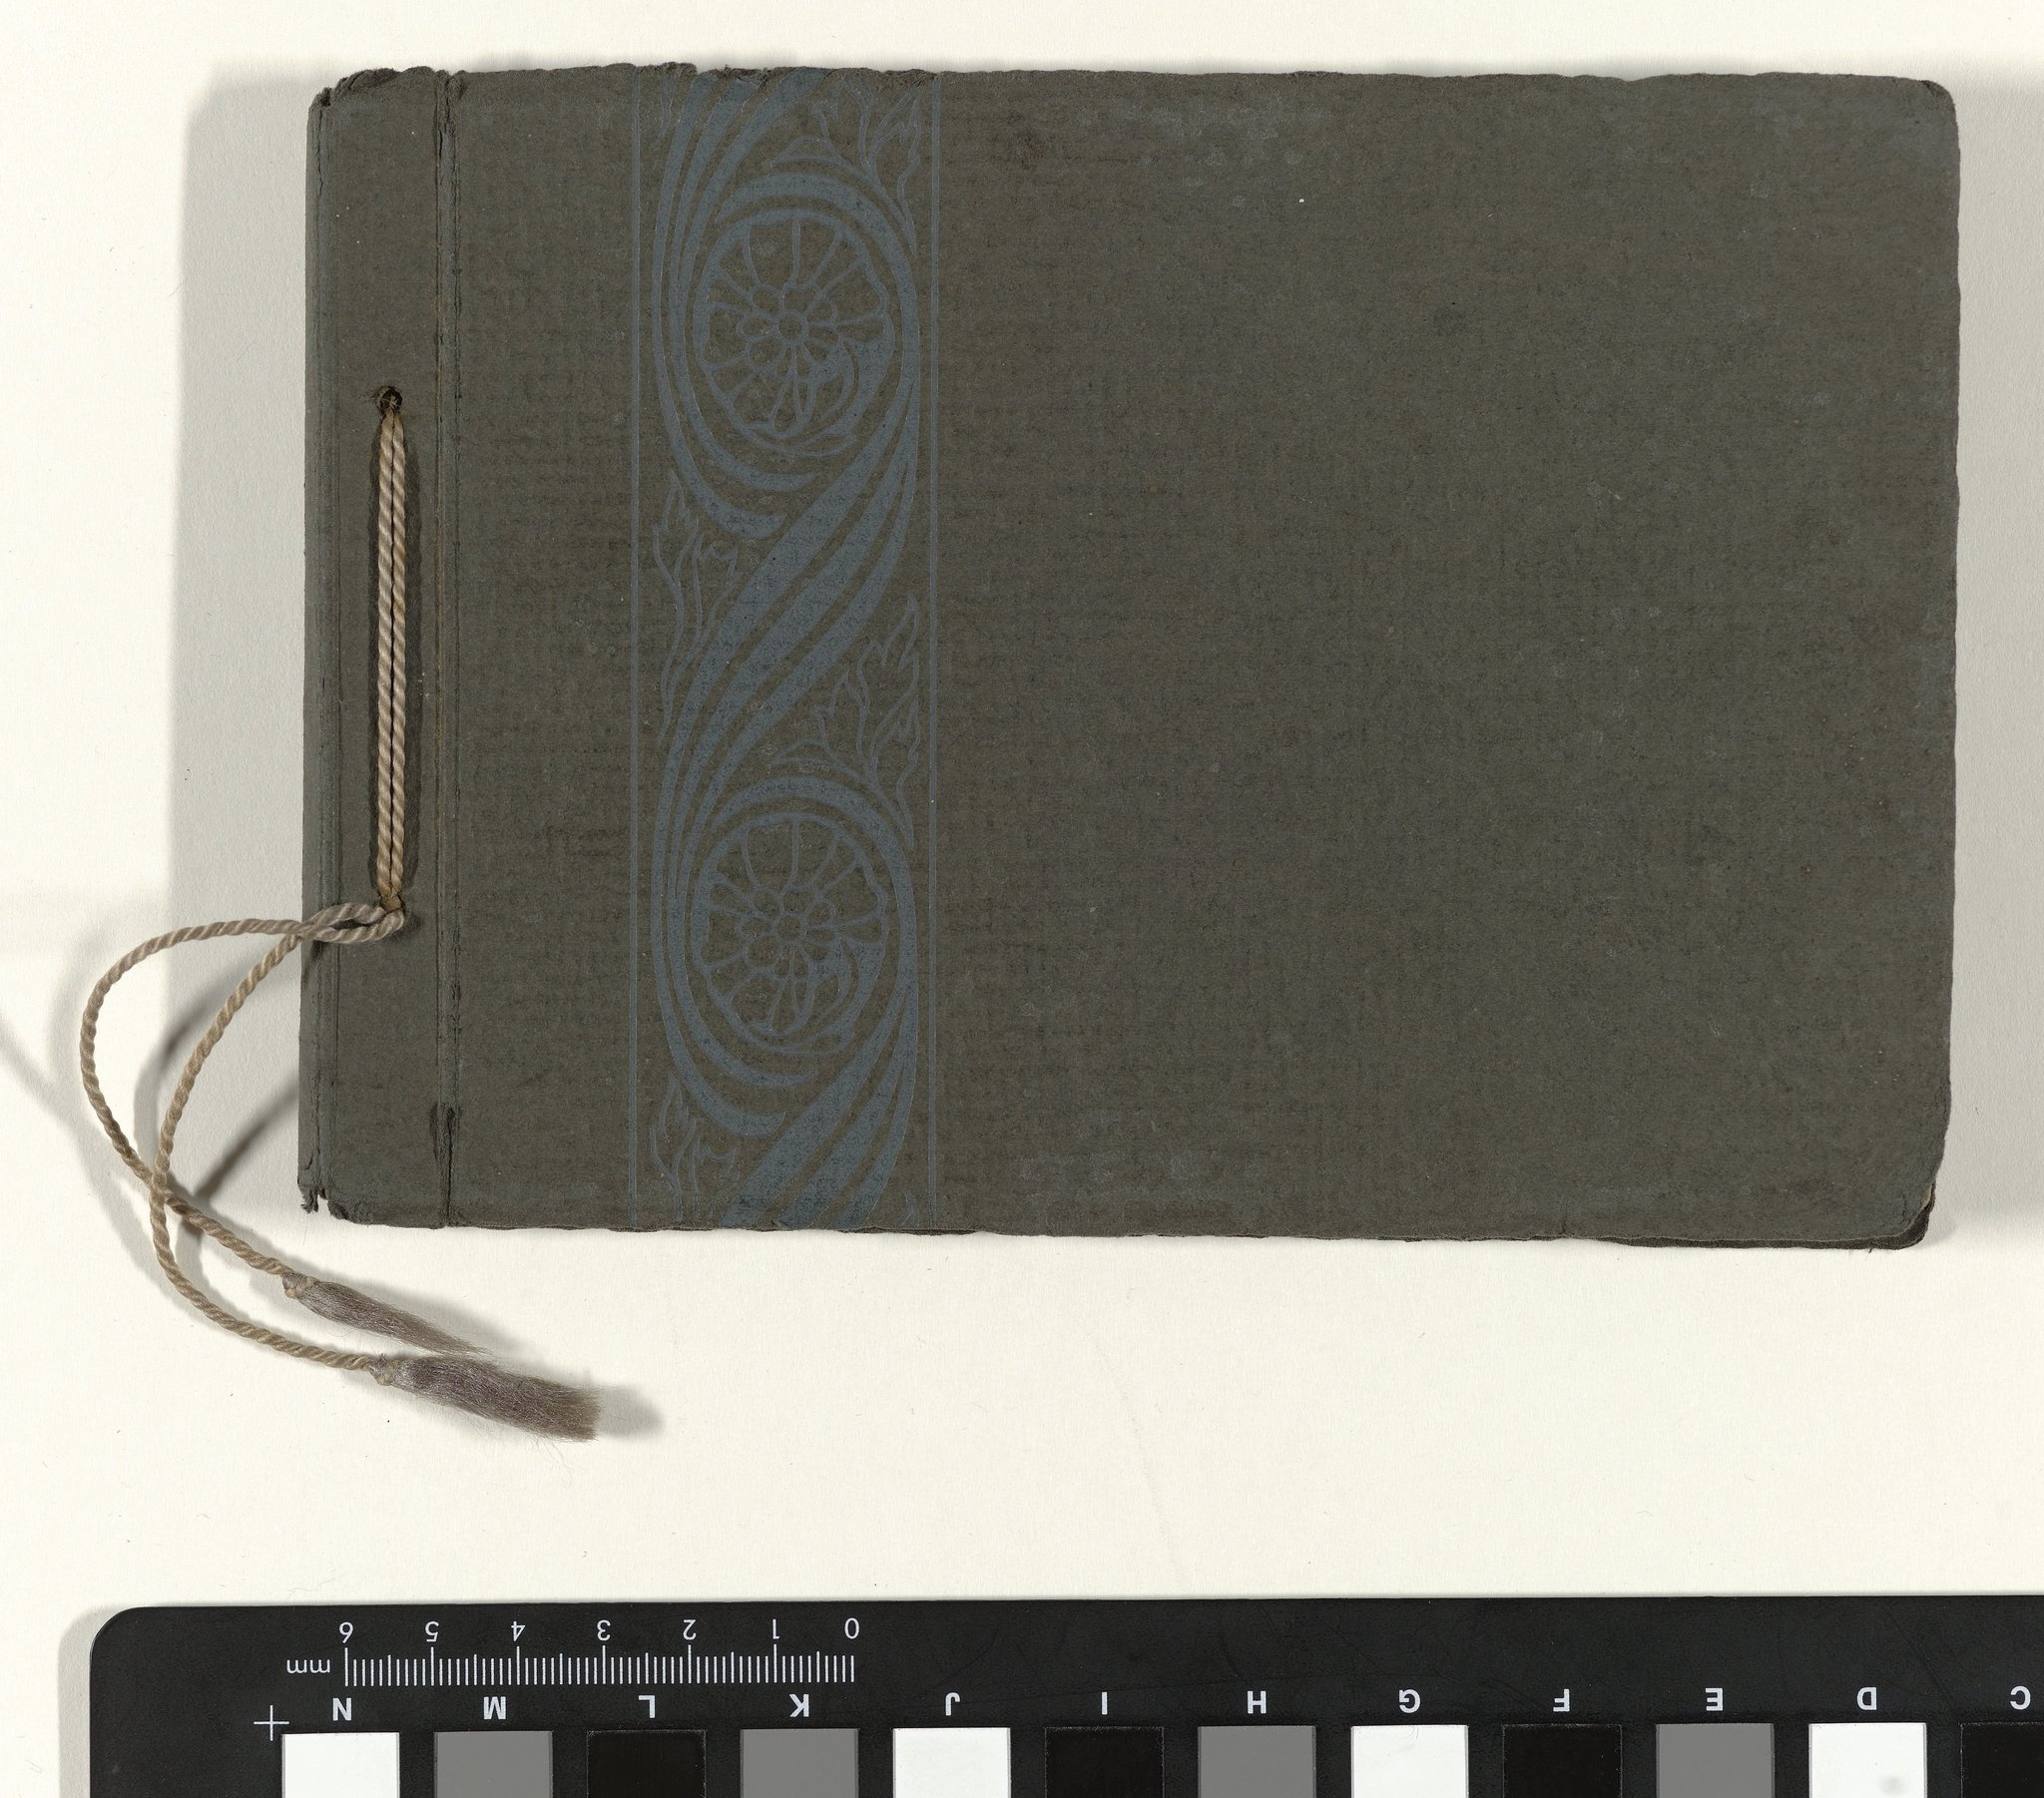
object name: photograph album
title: Fotoalbum familie Gonggrijp op de plantages Clevia en Morgenstond in Suriname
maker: Anonymous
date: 1910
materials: cardboard, photographic support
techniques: gelatin silver print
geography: suriname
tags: suriname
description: Klein fotoalbum in grijze omslag met bloemmotief. De 20 bladen worden bijeengehouden door een touwtje. Het album bevat 14 ingeplakte foto's en 1 losse foto van de familie Gonggrijp over het plantageleven op de plantages Clevia en Morgenstond in Suriname rond 1910.